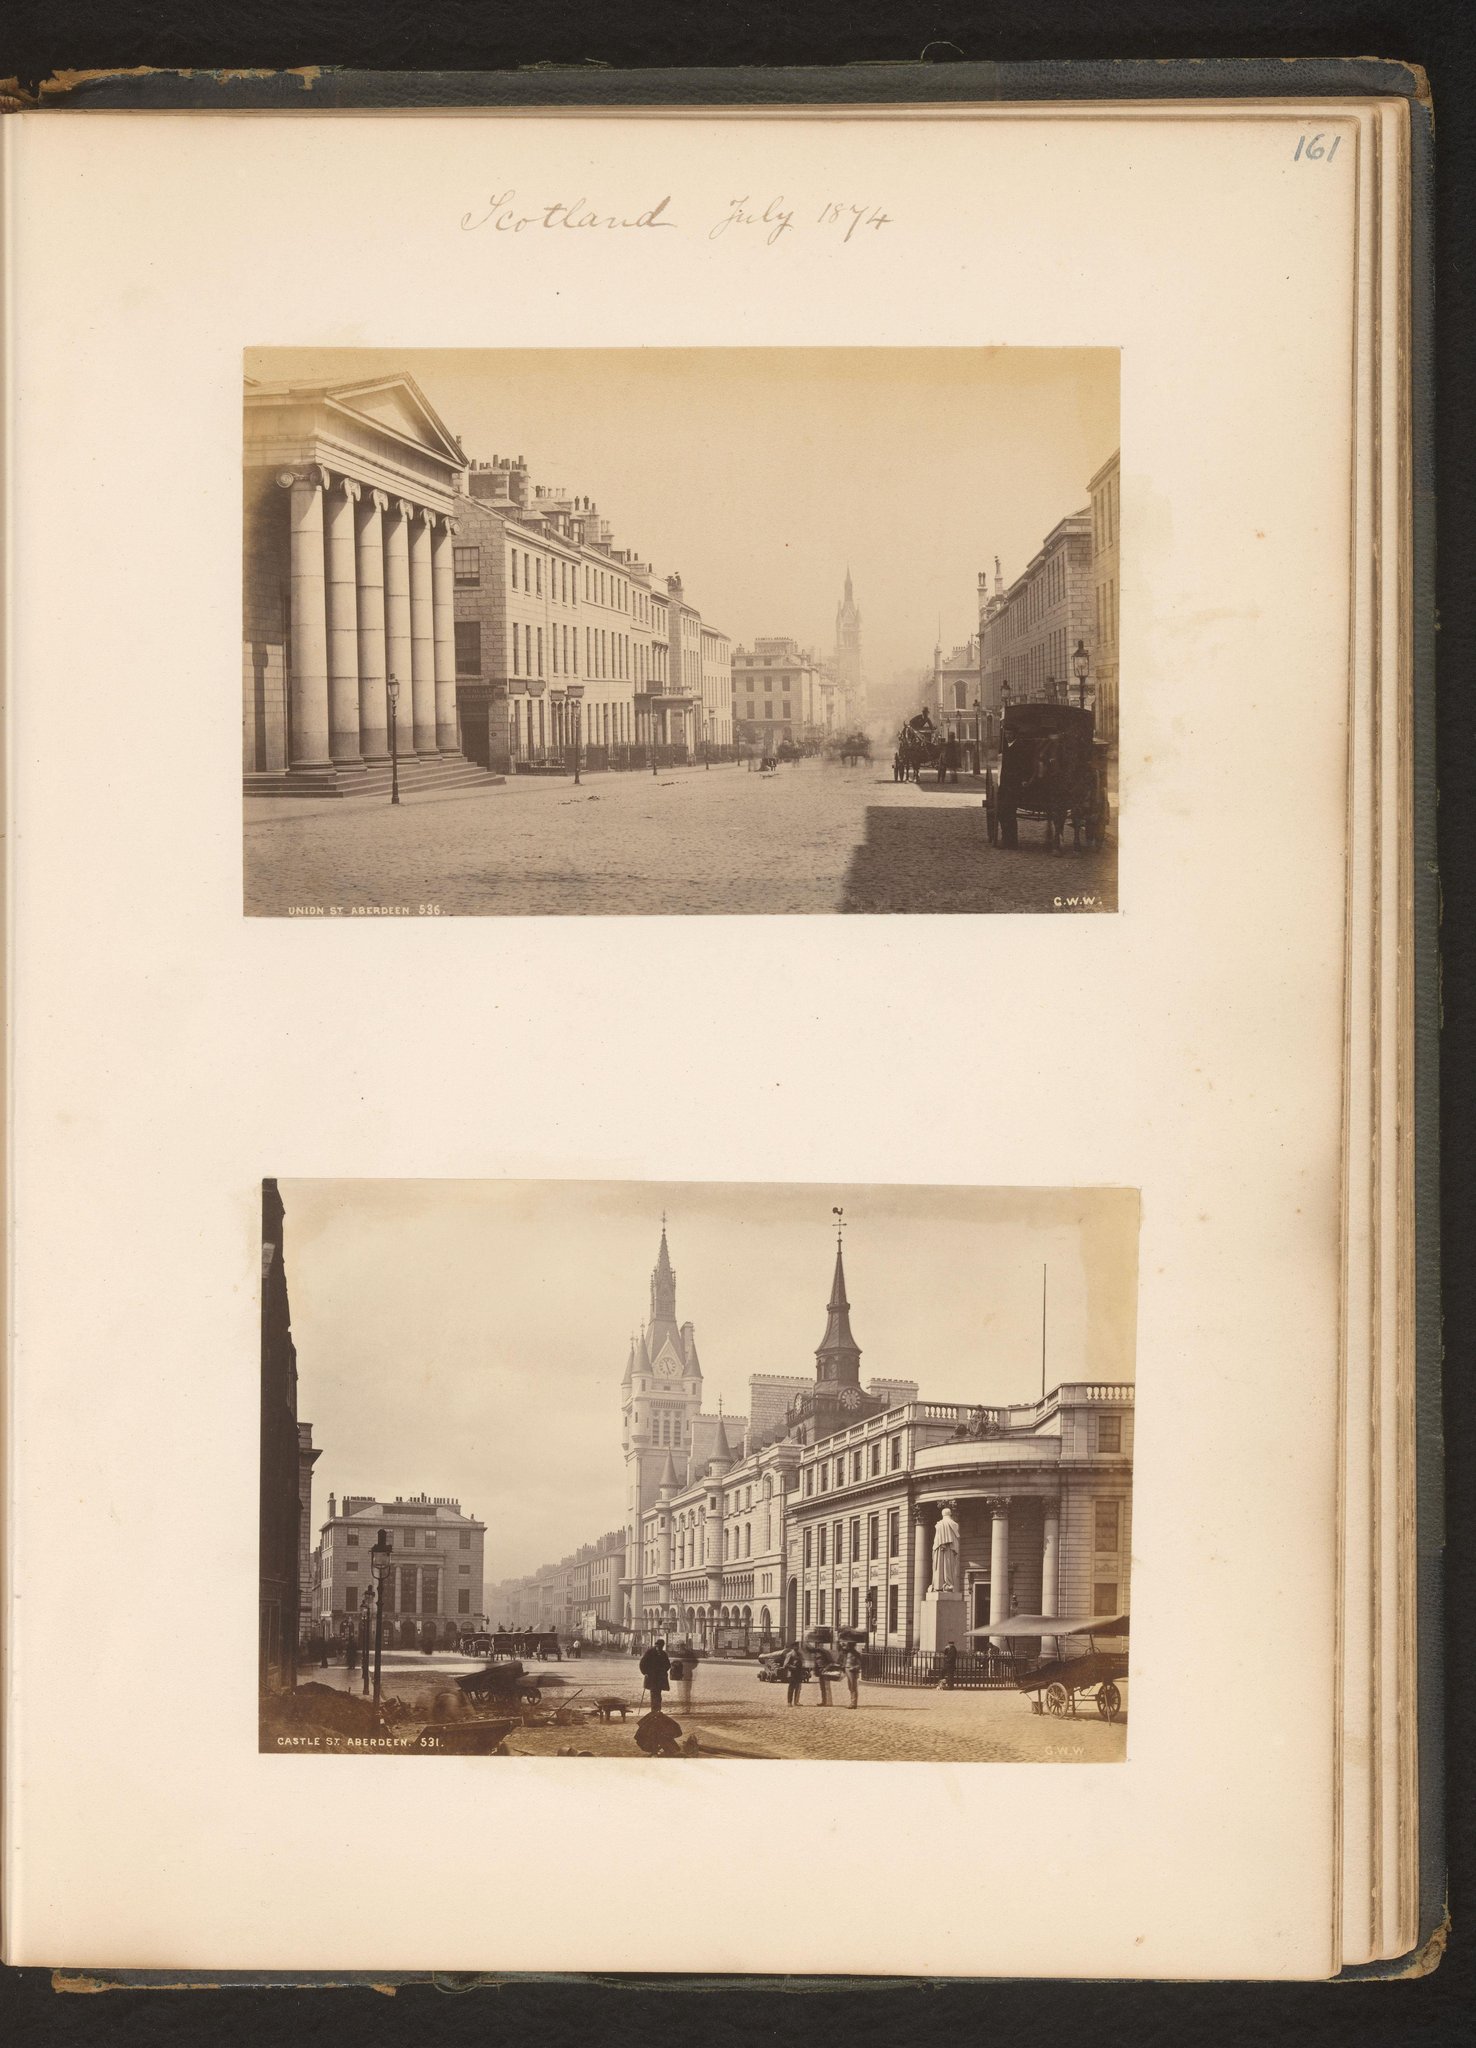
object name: album leaf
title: Gezichten op Aberdeen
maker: Anonymous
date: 1807-1874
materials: paper, photographic support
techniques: albumen print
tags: market cross, street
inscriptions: inscription: ‘Castle St Aberdeen 531 G.W.W.’, inscription: ‘Union St Aberdeen 536 G.W.W.’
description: Union Street en Castle Street met Mercat Cross te Aberdeen. Deze pagina maakt deel uit van een album.